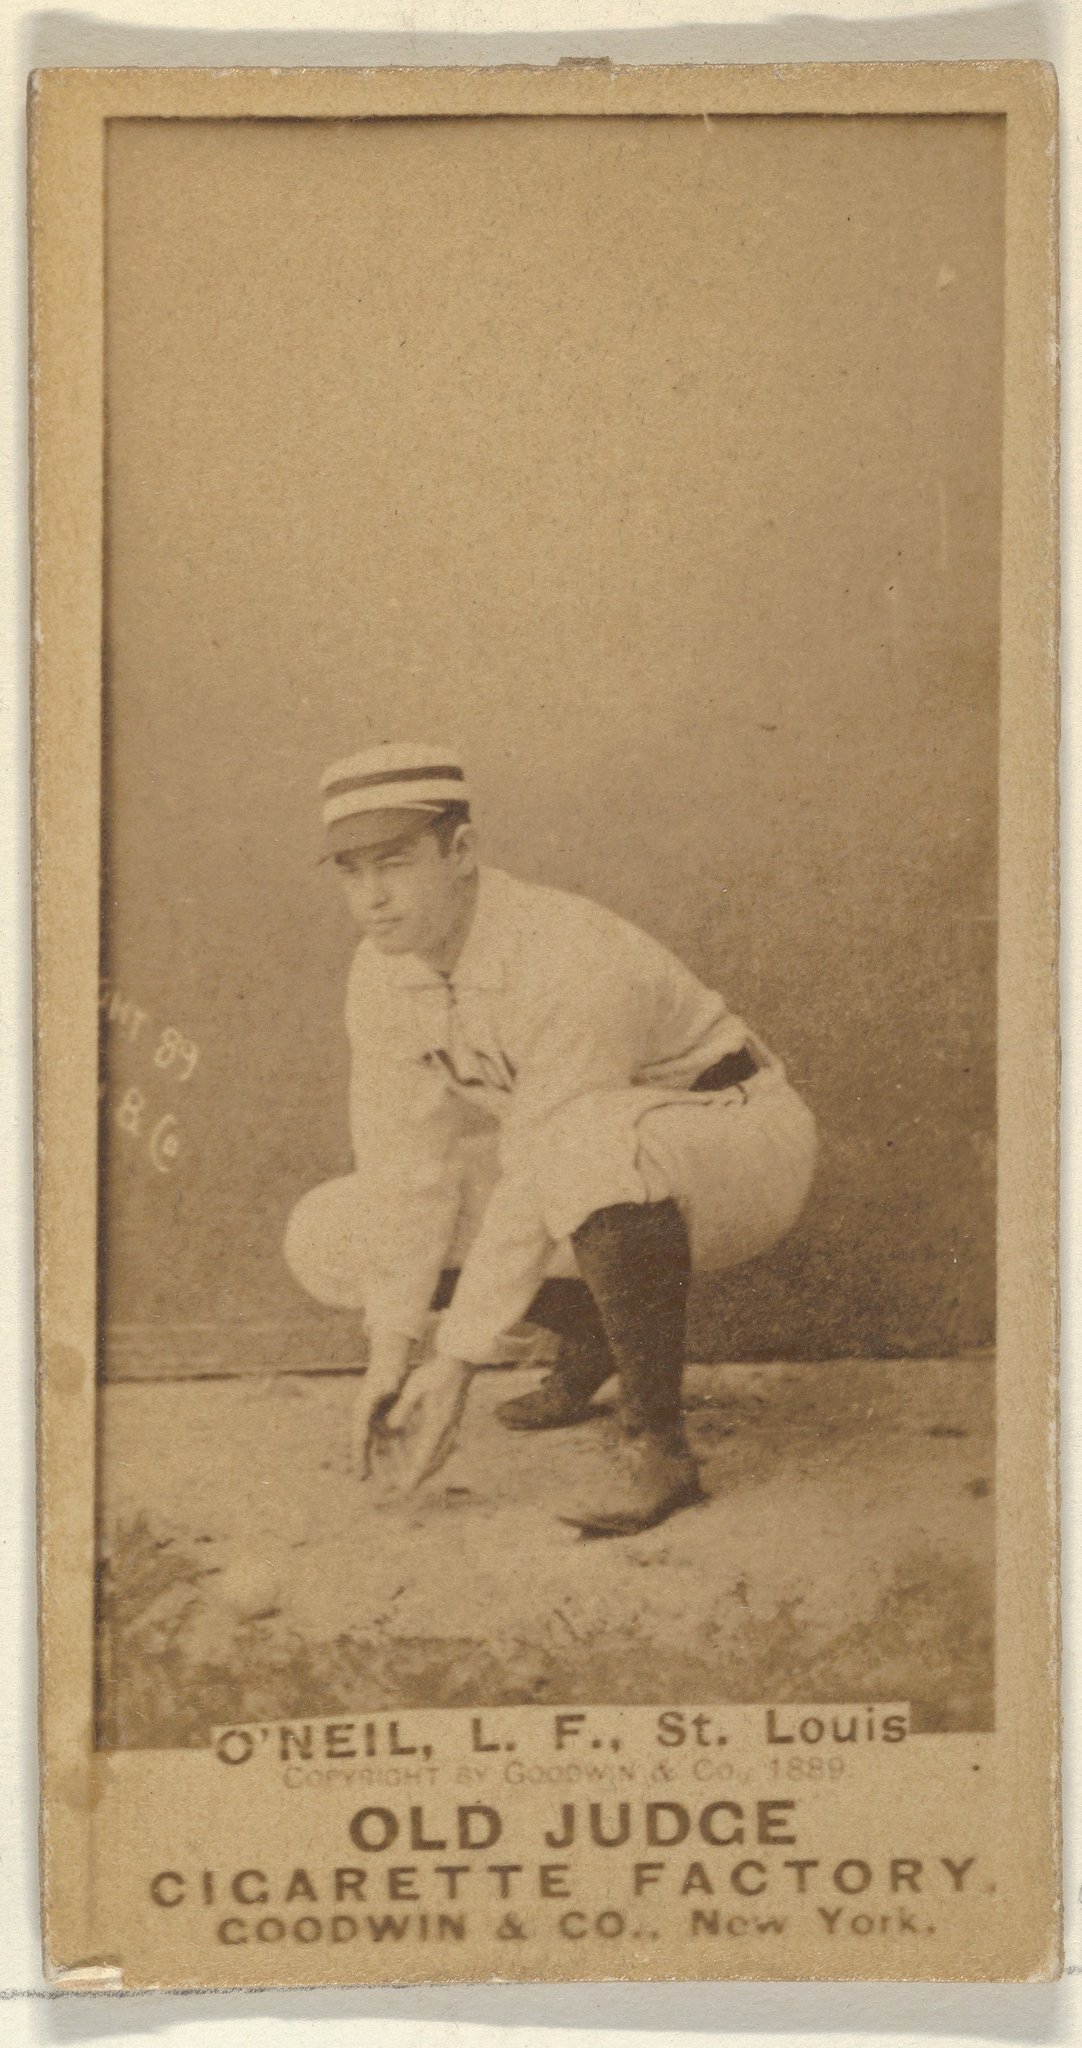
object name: baseball card, photograph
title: James Edward "Tip" O'Neill, Left Field, St. Louis Browns, from the Old Judge series (N172) for Old Judge Cigarettes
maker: goodwin & company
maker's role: publisher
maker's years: 1850-1950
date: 1889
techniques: albumen silver print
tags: men,portraits,baseball,athletes